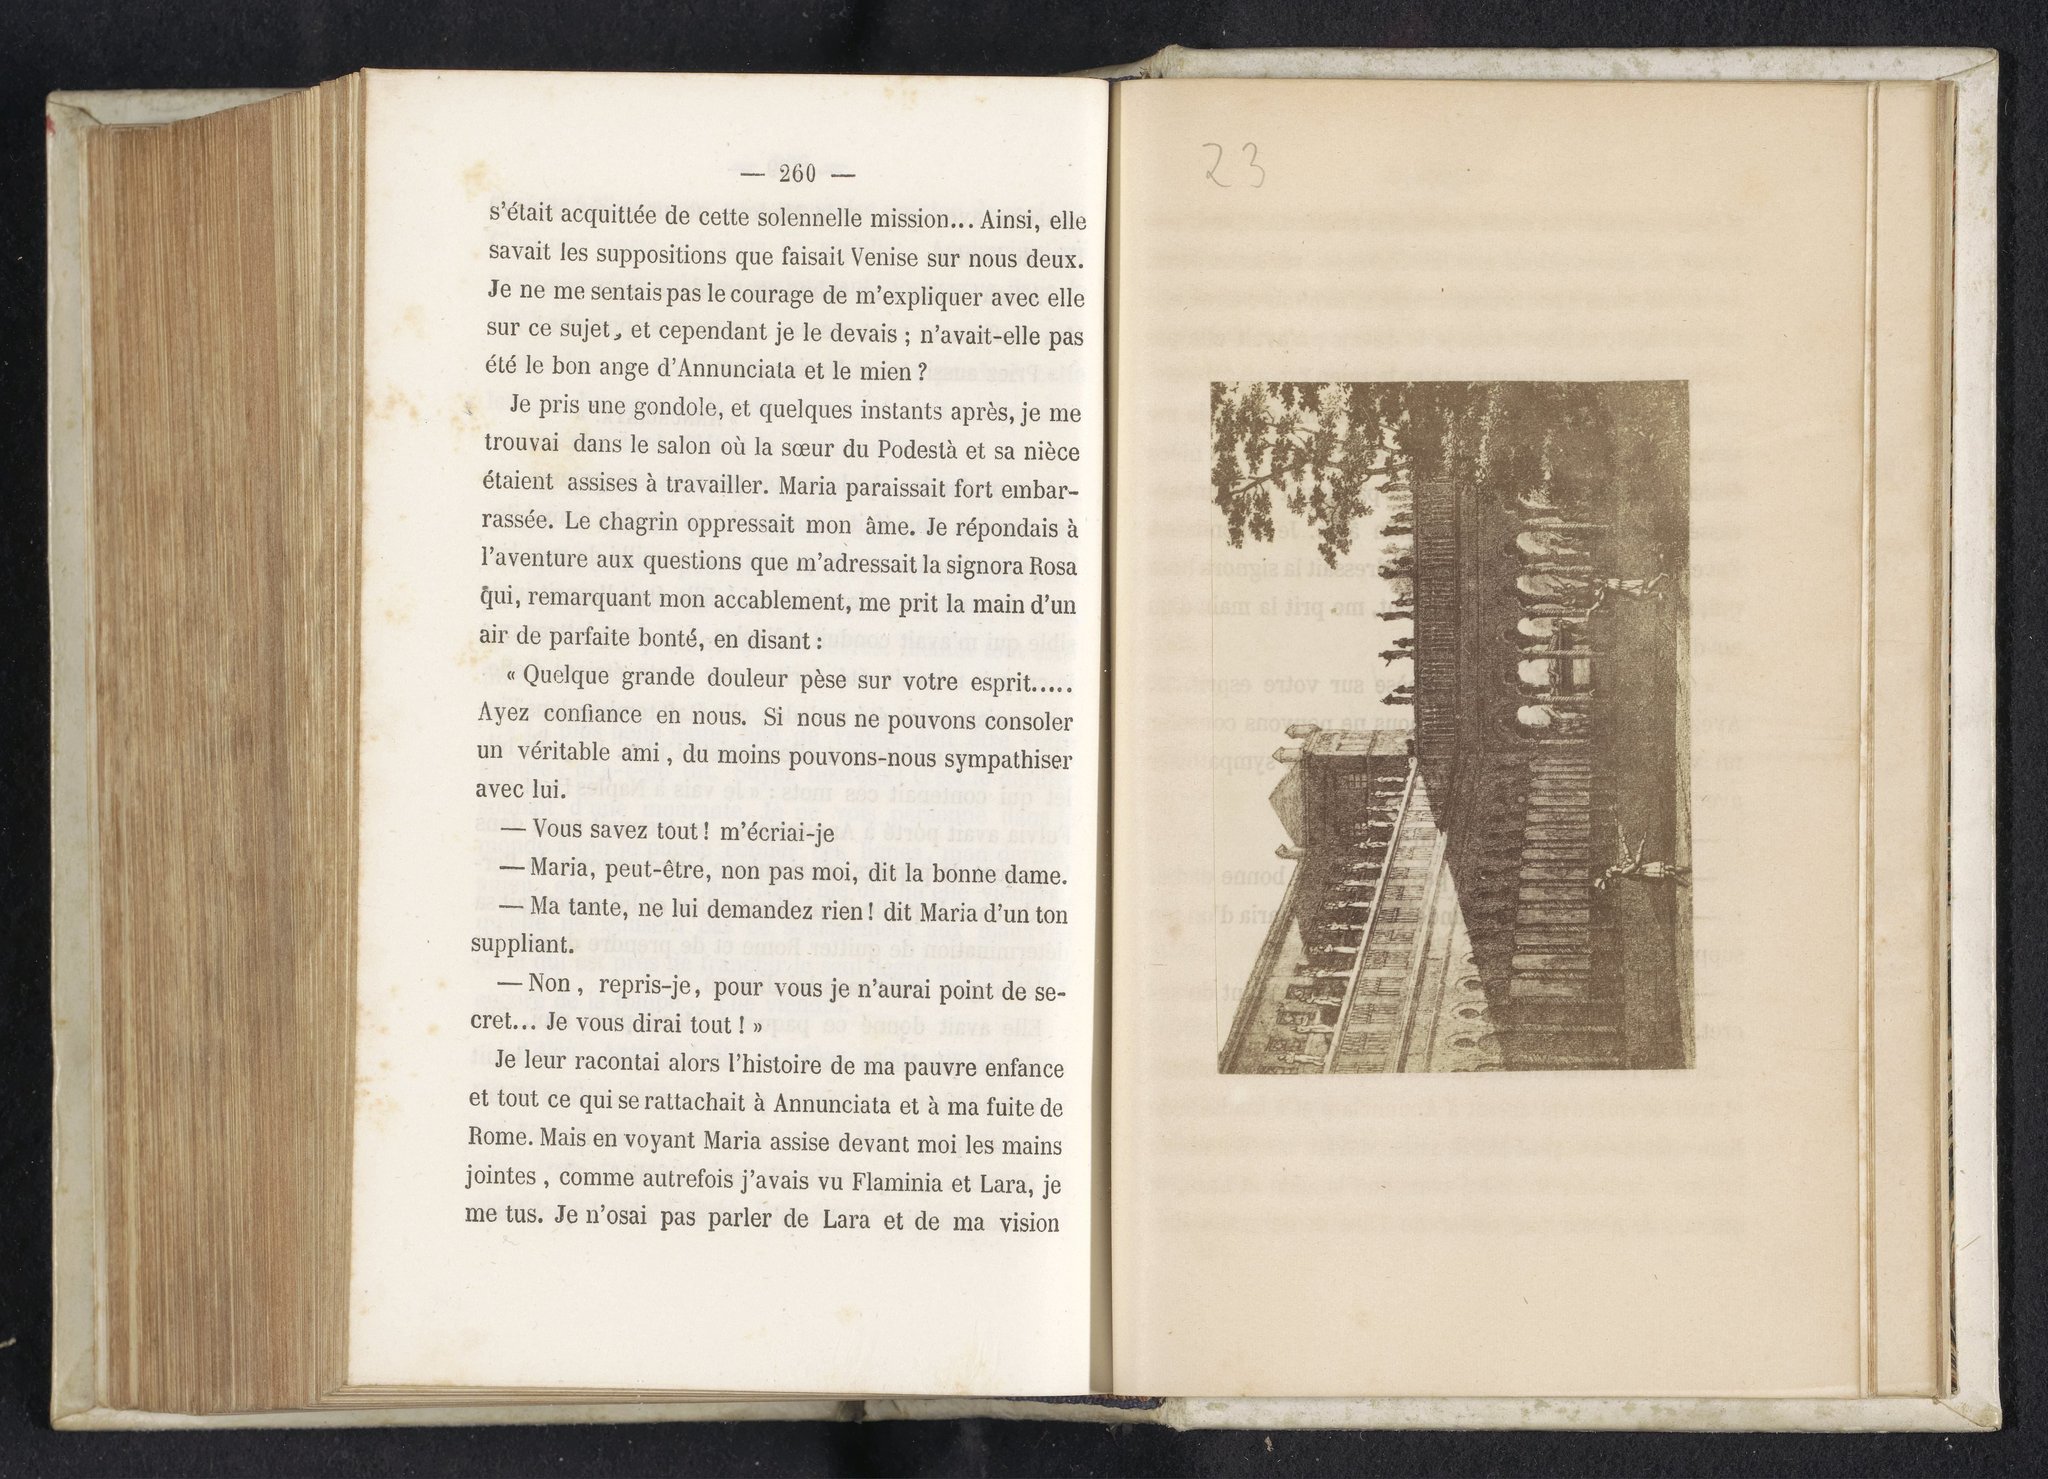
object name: page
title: Fotoreproductie van een prent, voorstellende een exterieur van (vermoedelijk) een paleis te Italië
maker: Anonymous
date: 1850-1860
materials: photographic support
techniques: albumen print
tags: palace, façade (of house or building)